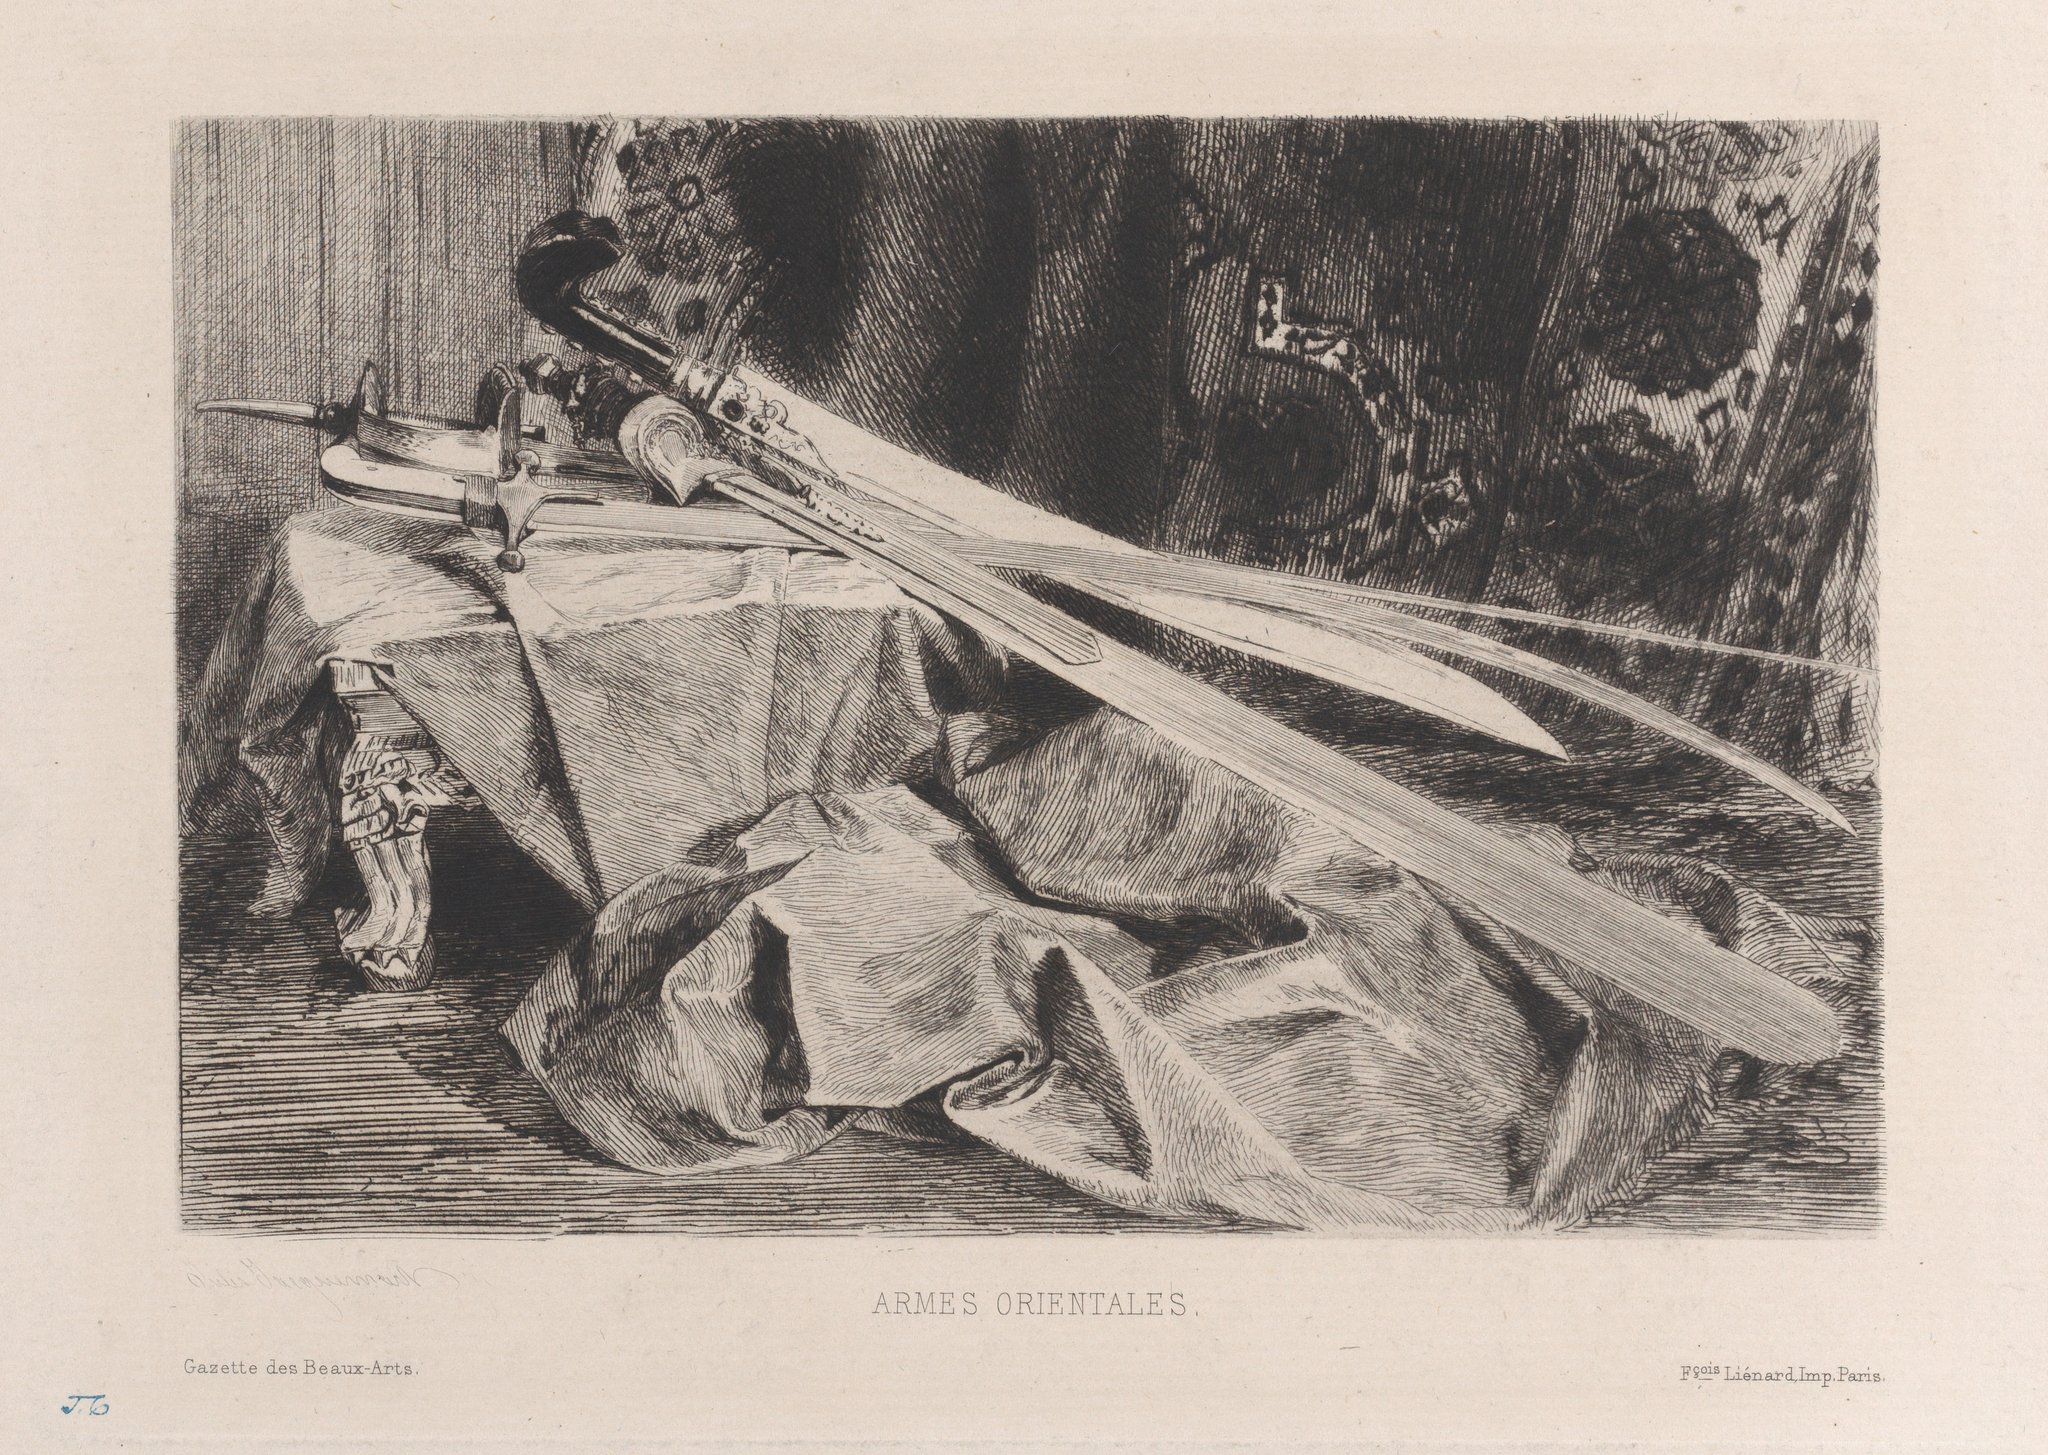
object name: print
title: Oriental Arms, from "Gazette des Beaux-Arts"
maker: jules-ferdinand jacquemart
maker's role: artist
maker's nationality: french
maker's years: 1837-1880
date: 1875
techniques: etching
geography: paris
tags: swords